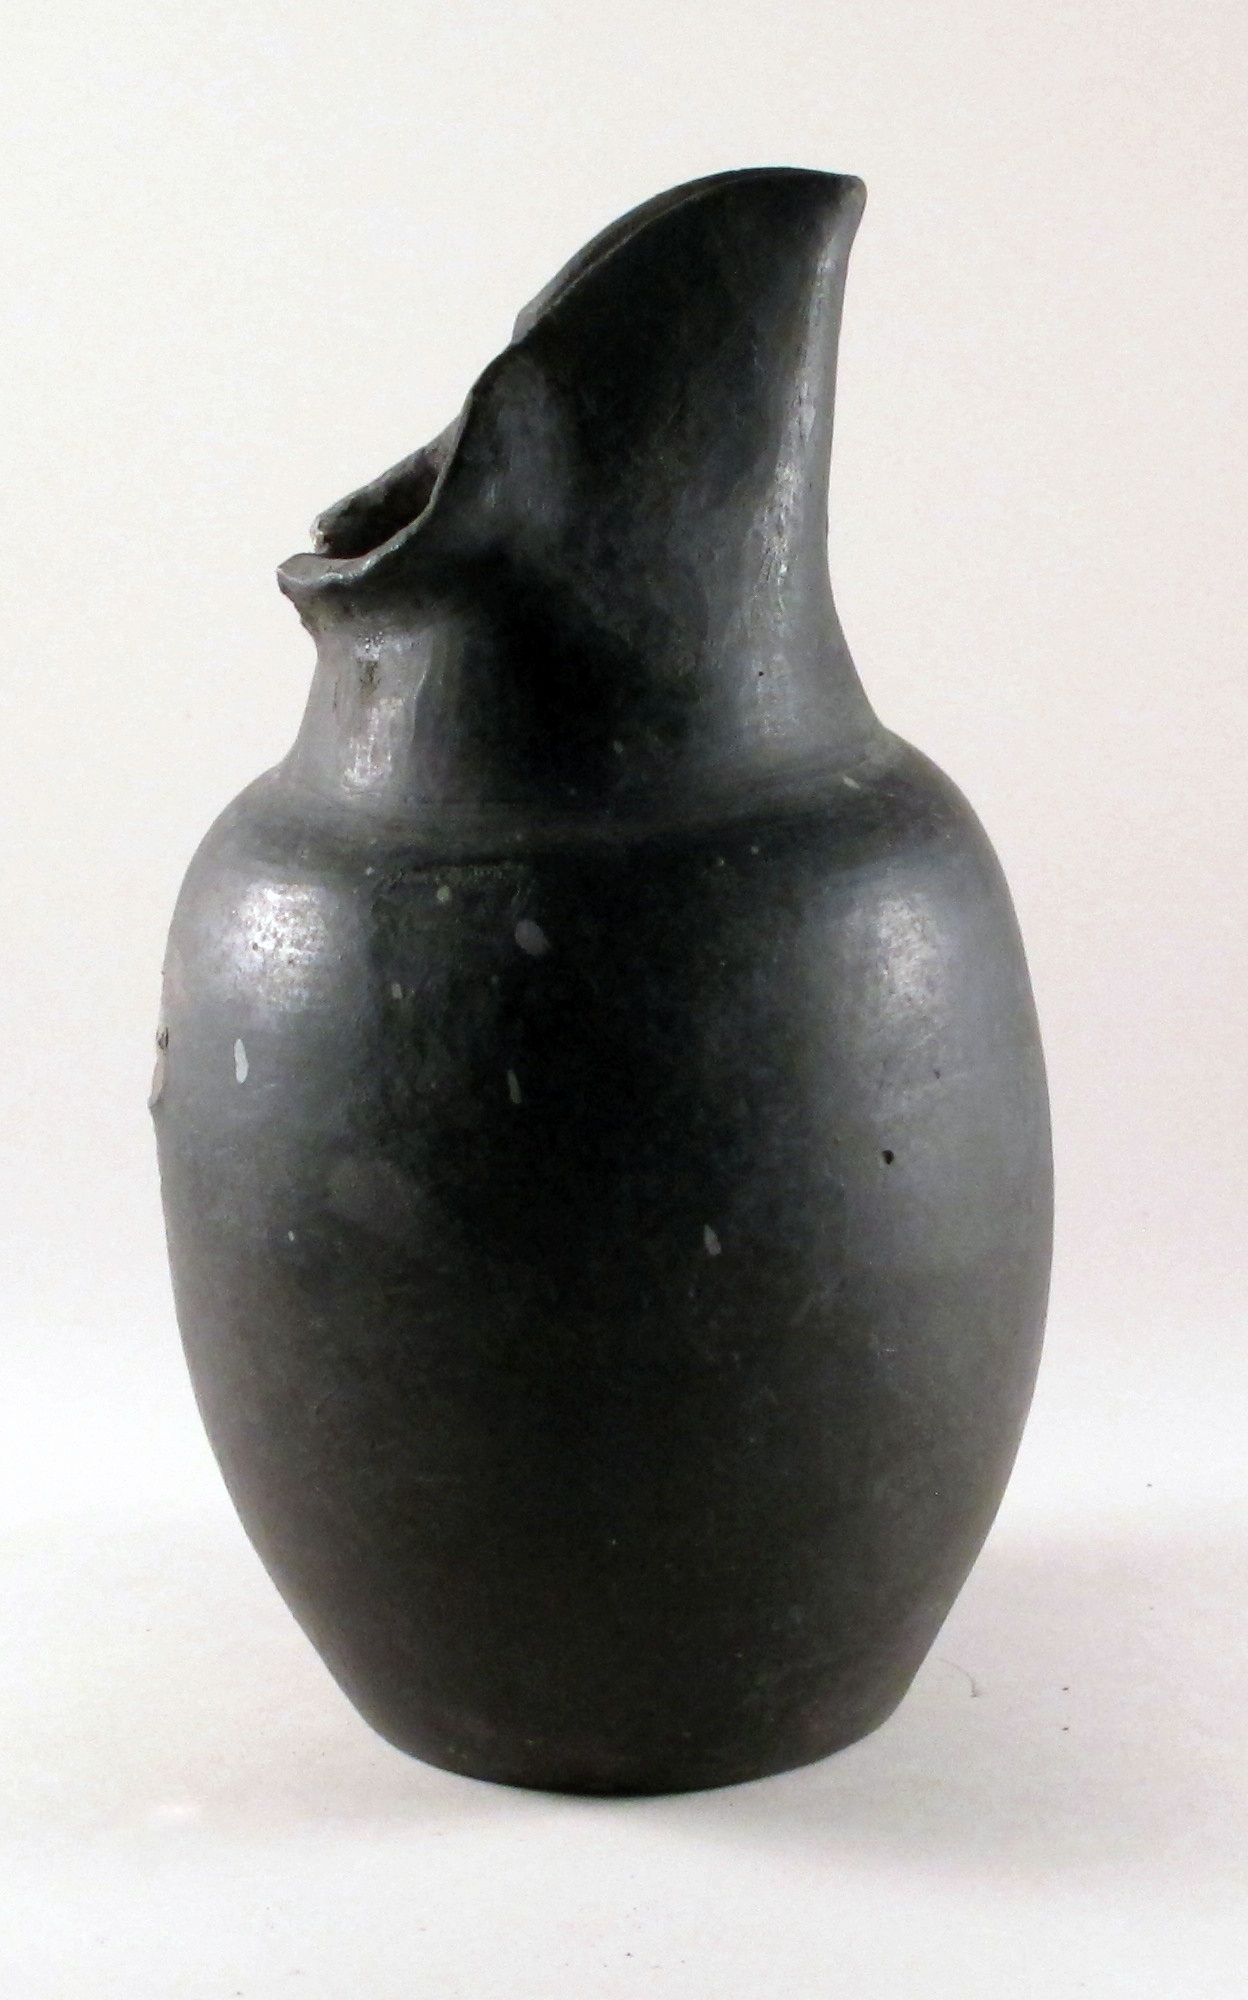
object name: oinochoe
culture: etruscan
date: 550-500 BCE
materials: terracotta